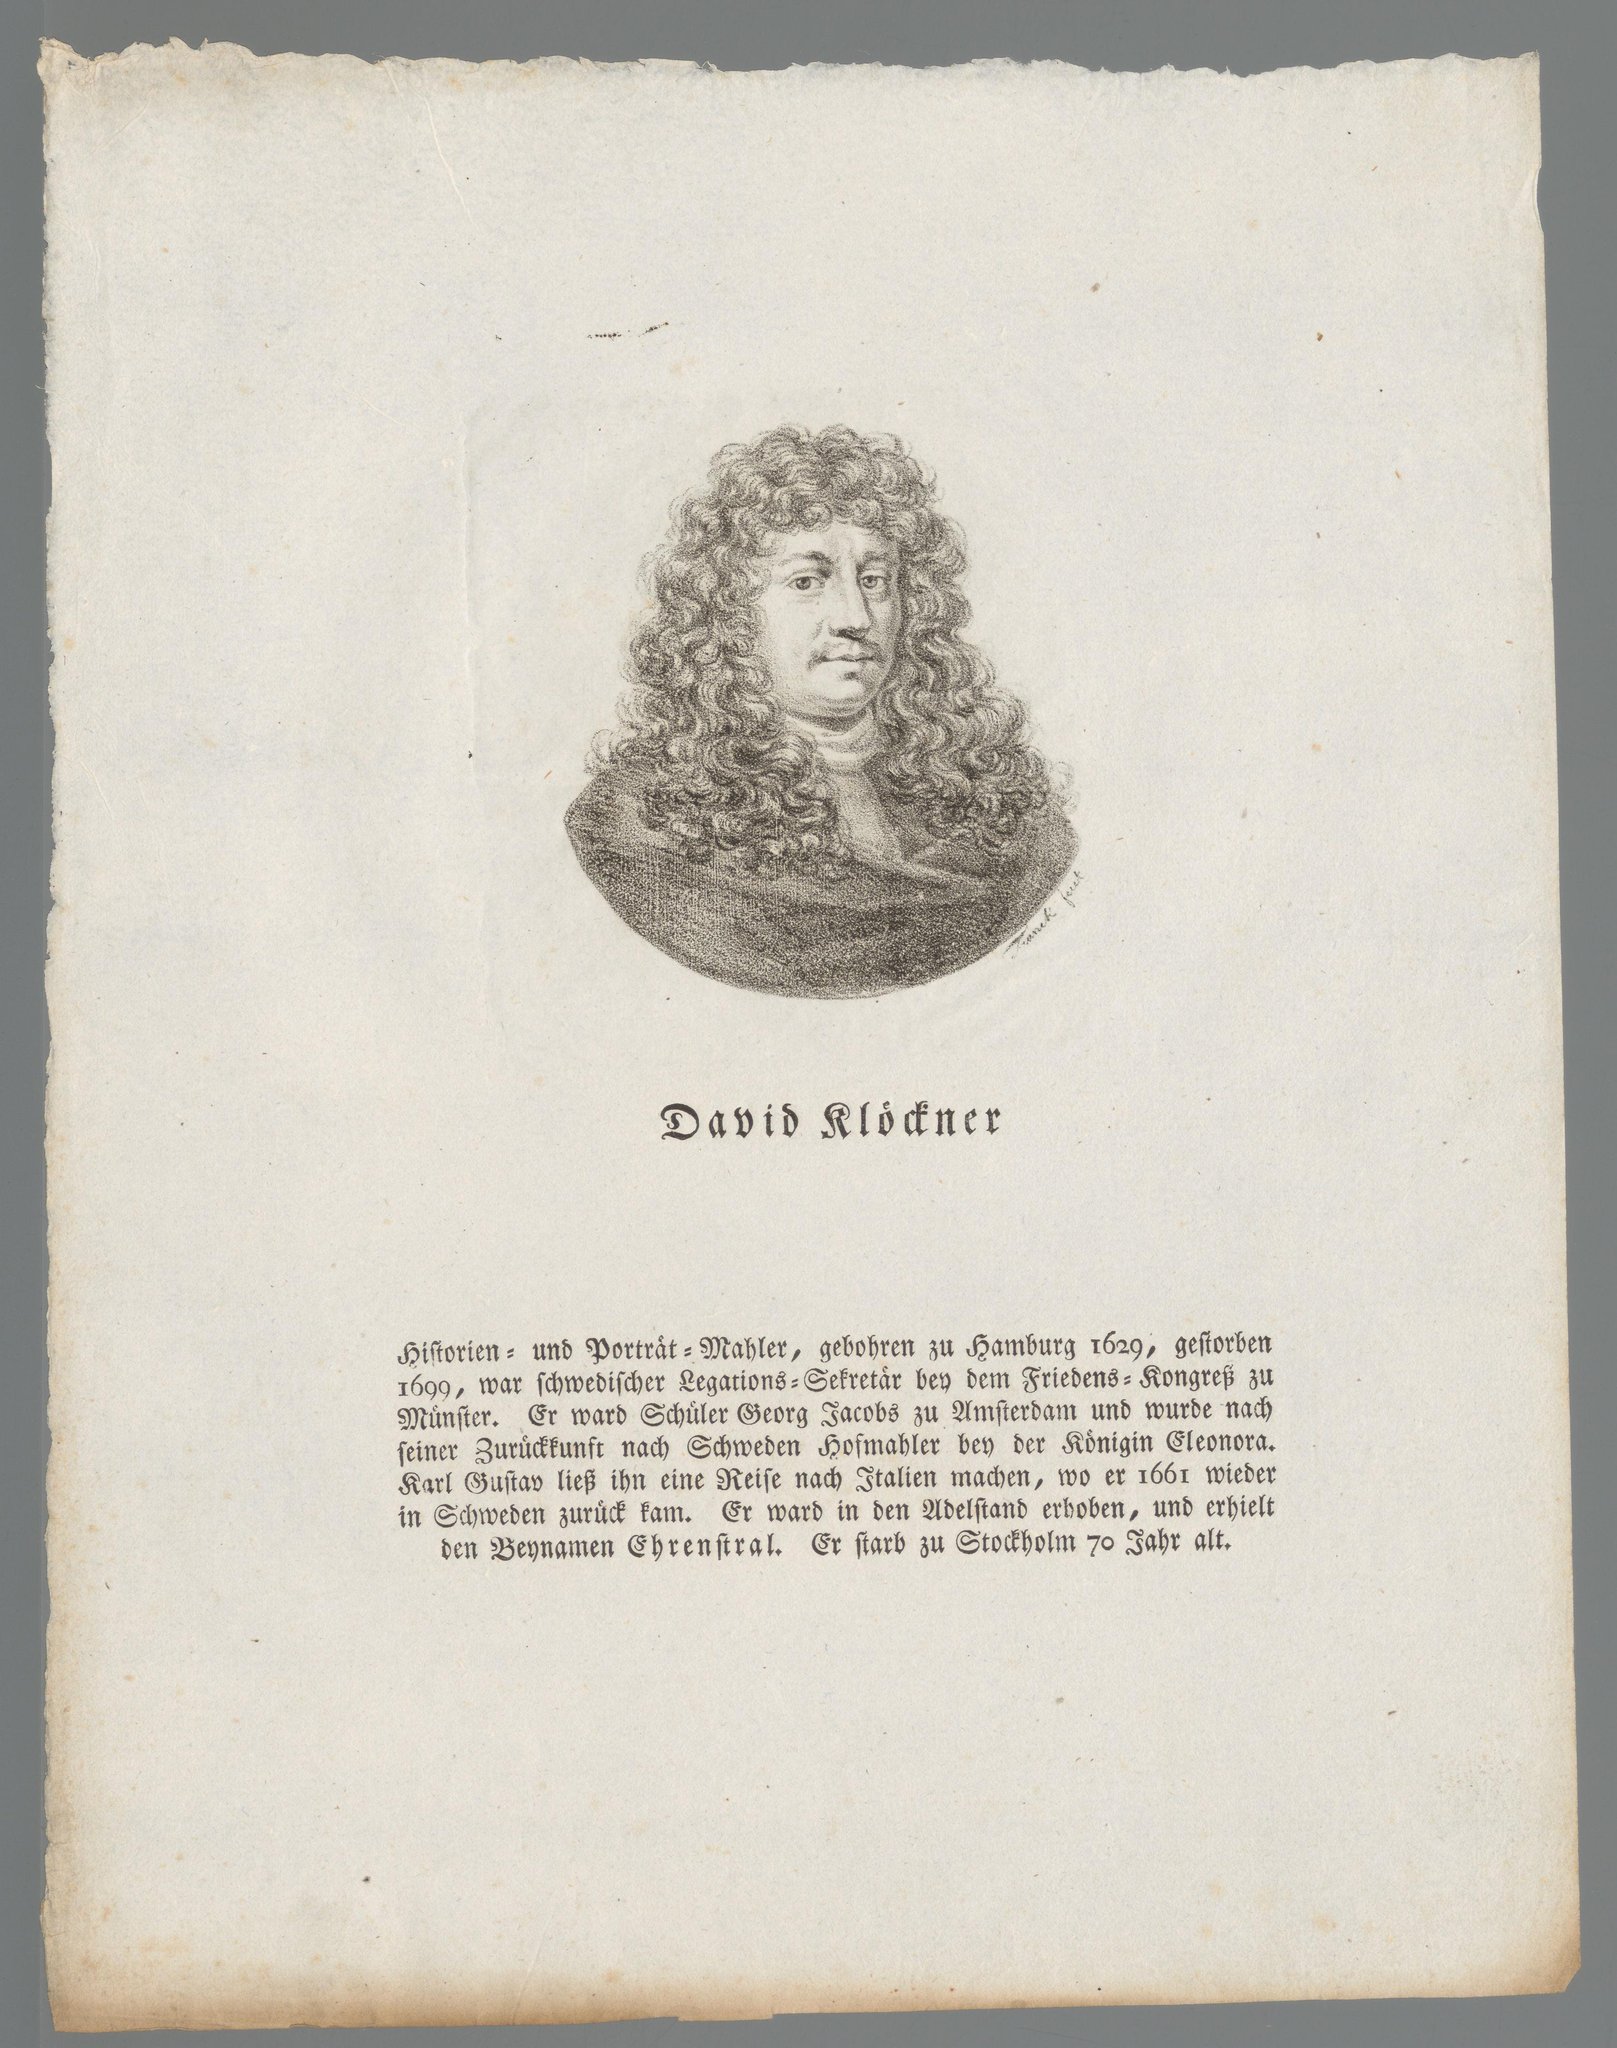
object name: book illustration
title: David Kloeckner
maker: maximilian franck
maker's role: print maker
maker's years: 1780-1830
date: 1813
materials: paper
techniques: letterpress printing, lithograph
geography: munich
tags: painter, david ehrenstrahl, historical persons, portrait, self-portrait of painter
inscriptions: collector's mark: Lugt 2228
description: Prent uit: Lindauer, Joseph. Deutsche Künstler-Gallerie. München: Maximilian Franck, 1813.